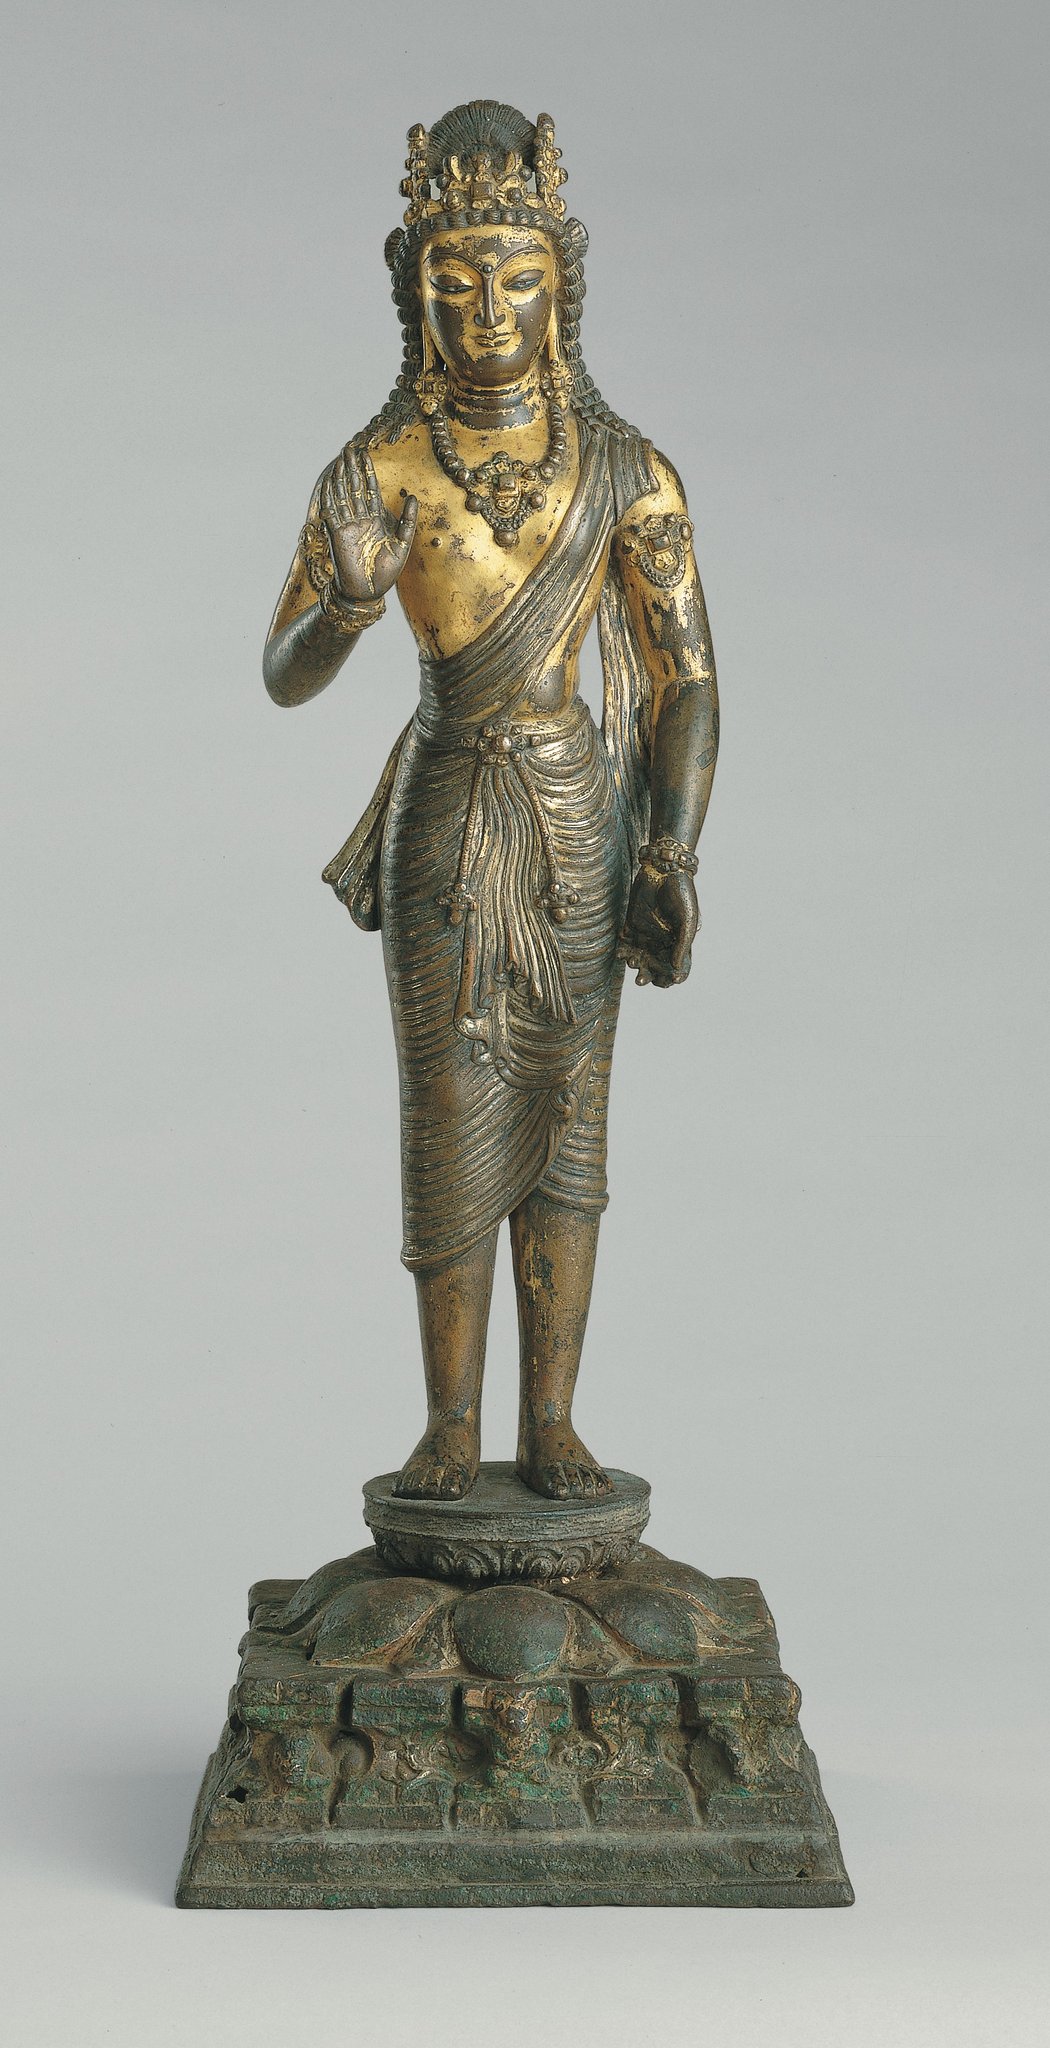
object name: figure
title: Standing Bodhisattva Maitreya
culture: pakistani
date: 701-733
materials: copper alloy, silver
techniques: gilding, inlay, silvered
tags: buddhism,bodhisattvas,maitreya